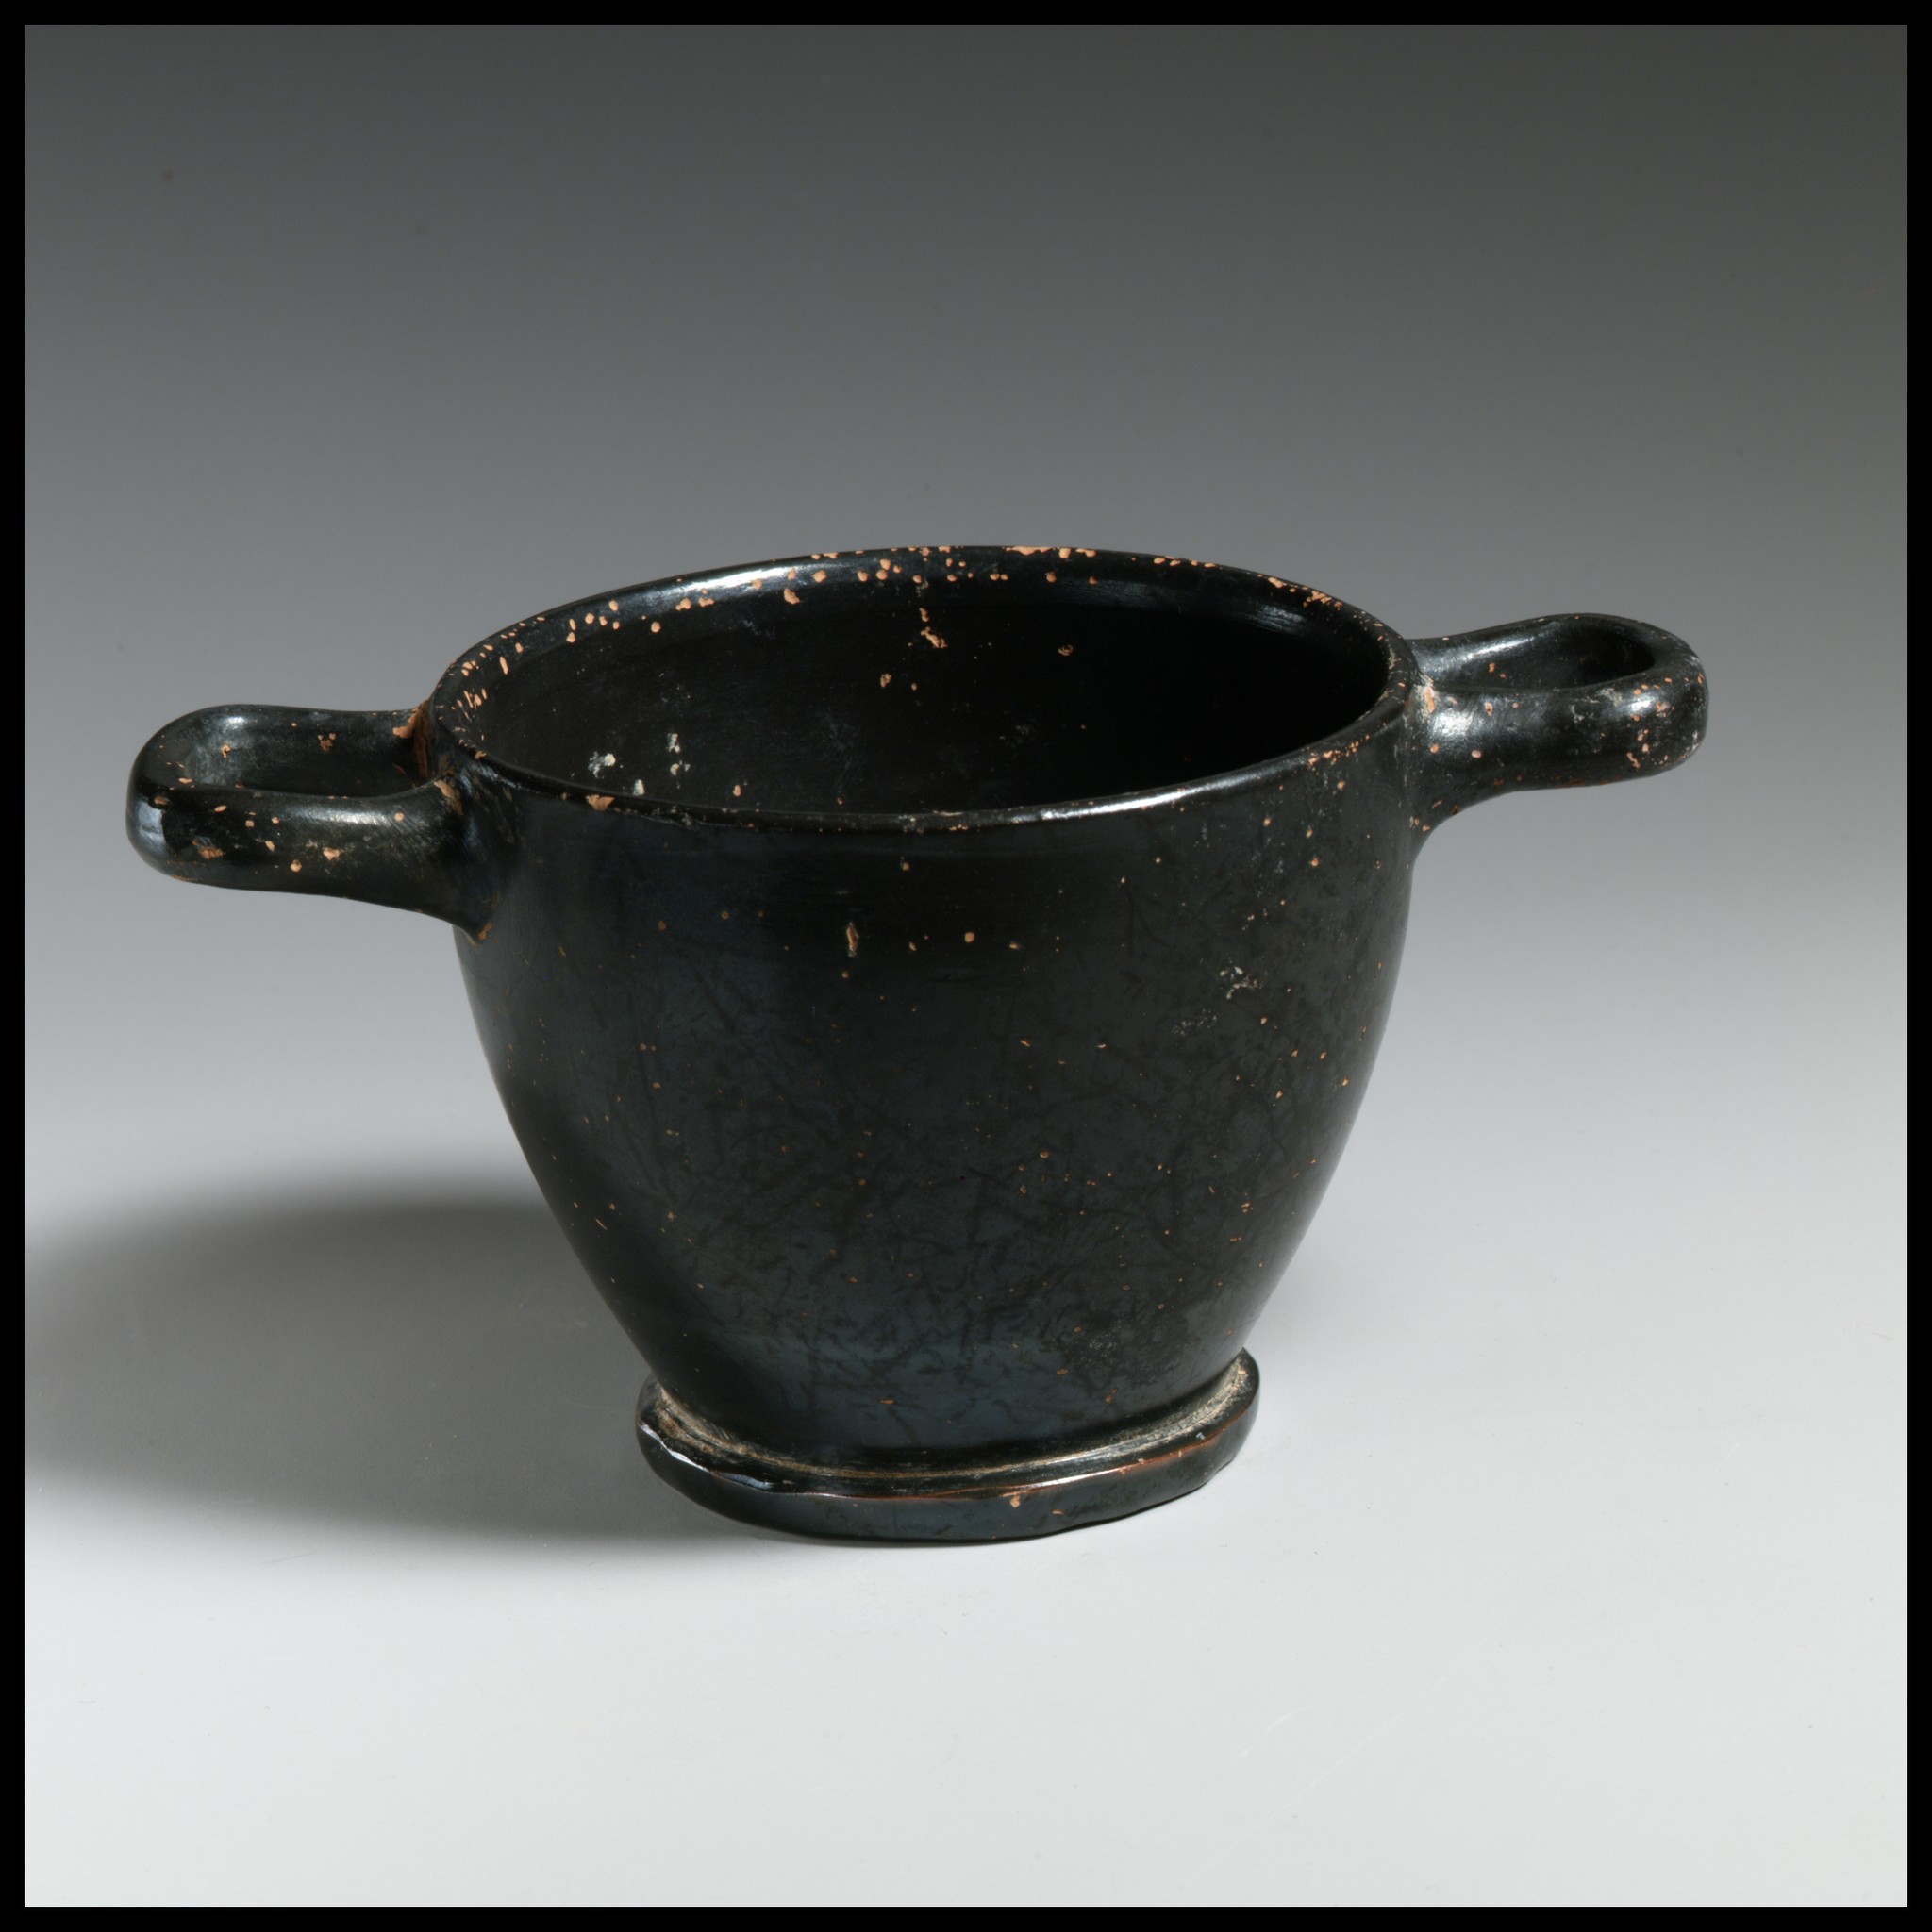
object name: skyphos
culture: greek, south italian, apulian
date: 7000-30 BCE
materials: terracotta